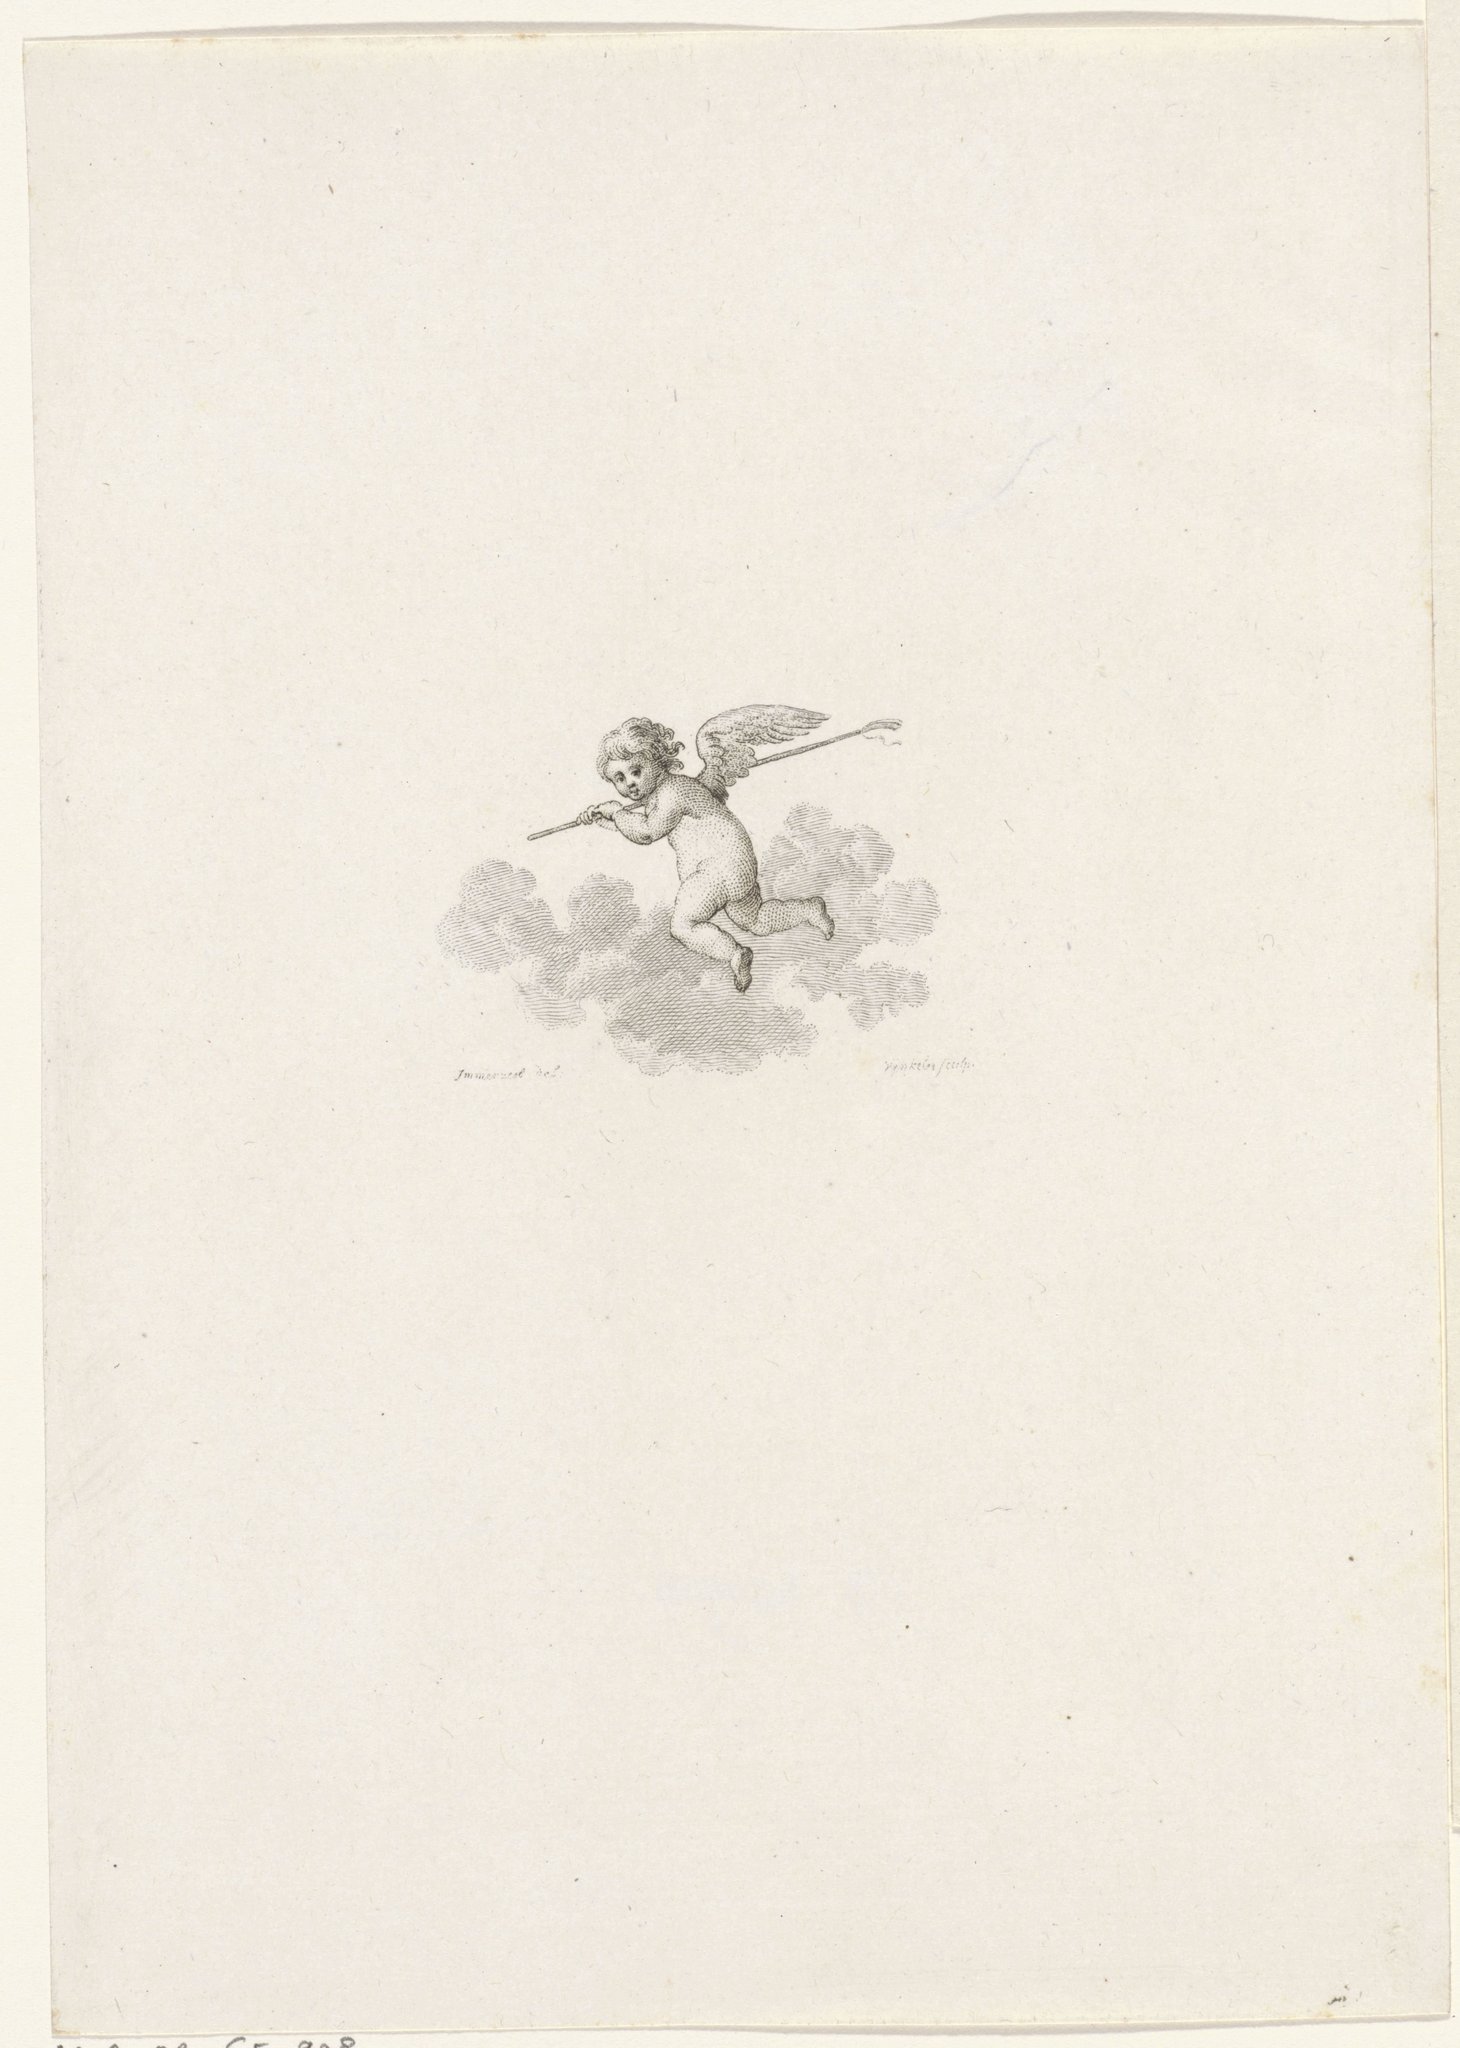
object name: print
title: Putto met een lange stok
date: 1751-1816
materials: paper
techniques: etching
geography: amsterdam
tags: walking-stick, staff, cupids: 'amores', 'amoretti', 'putti'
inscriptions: collector's mark: Lugt 2228